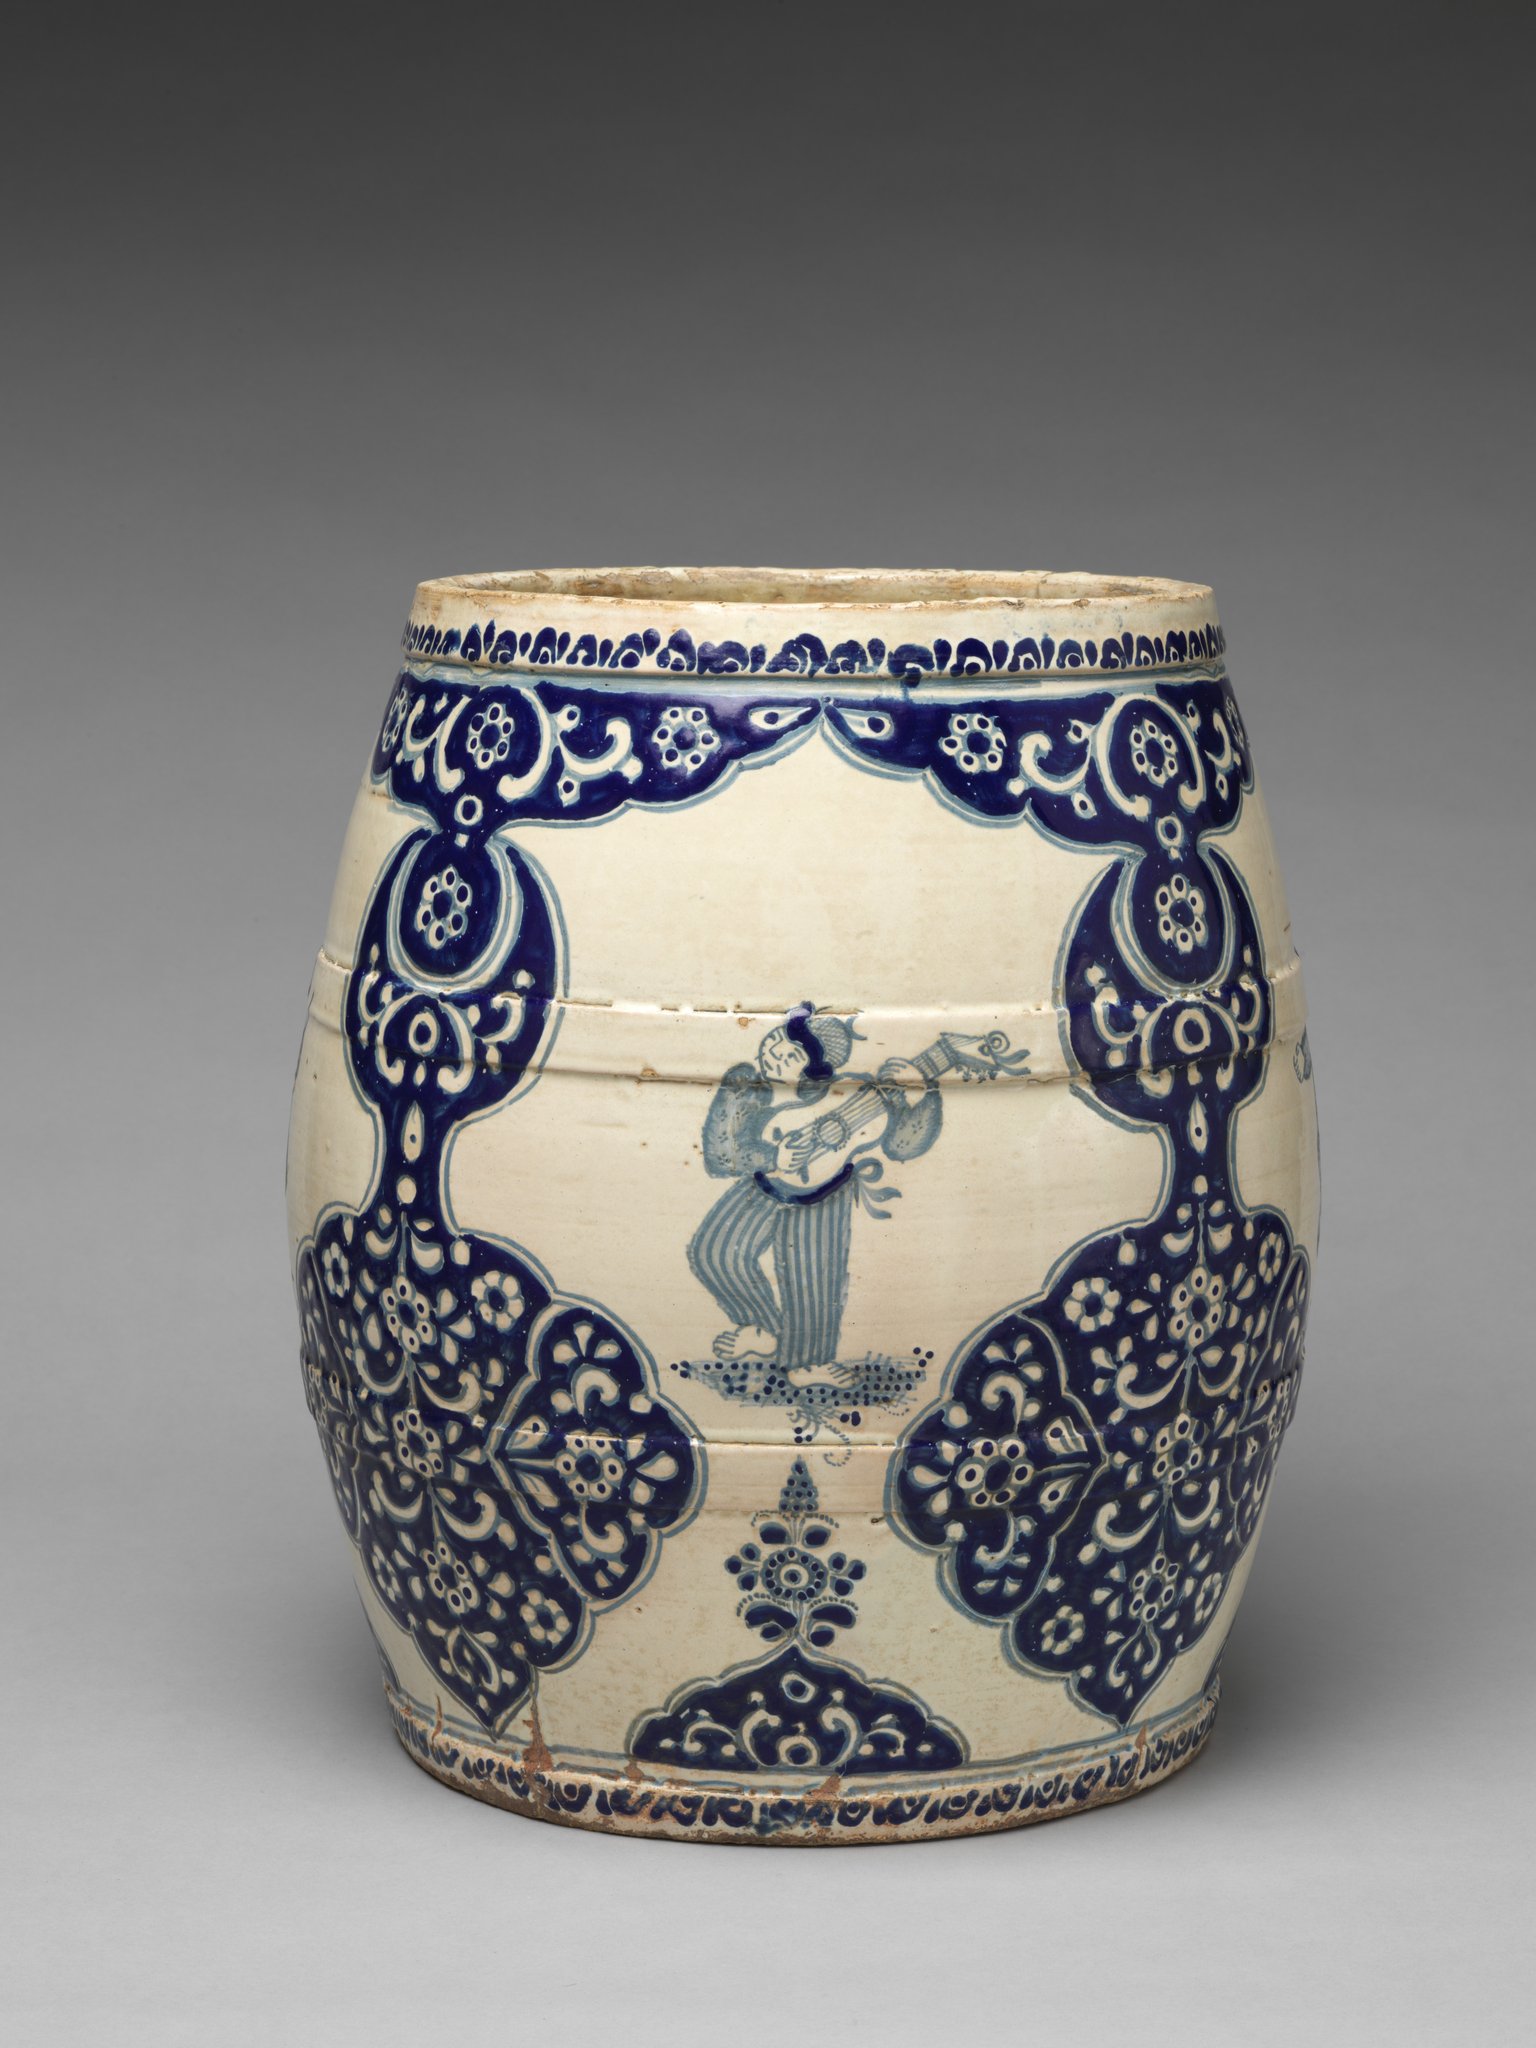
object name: flower pot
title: Barrel-shaped planter with Chinese figures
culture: mexican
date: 1760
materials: earthenware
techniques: glazing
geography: mexico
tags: musical instruments,men